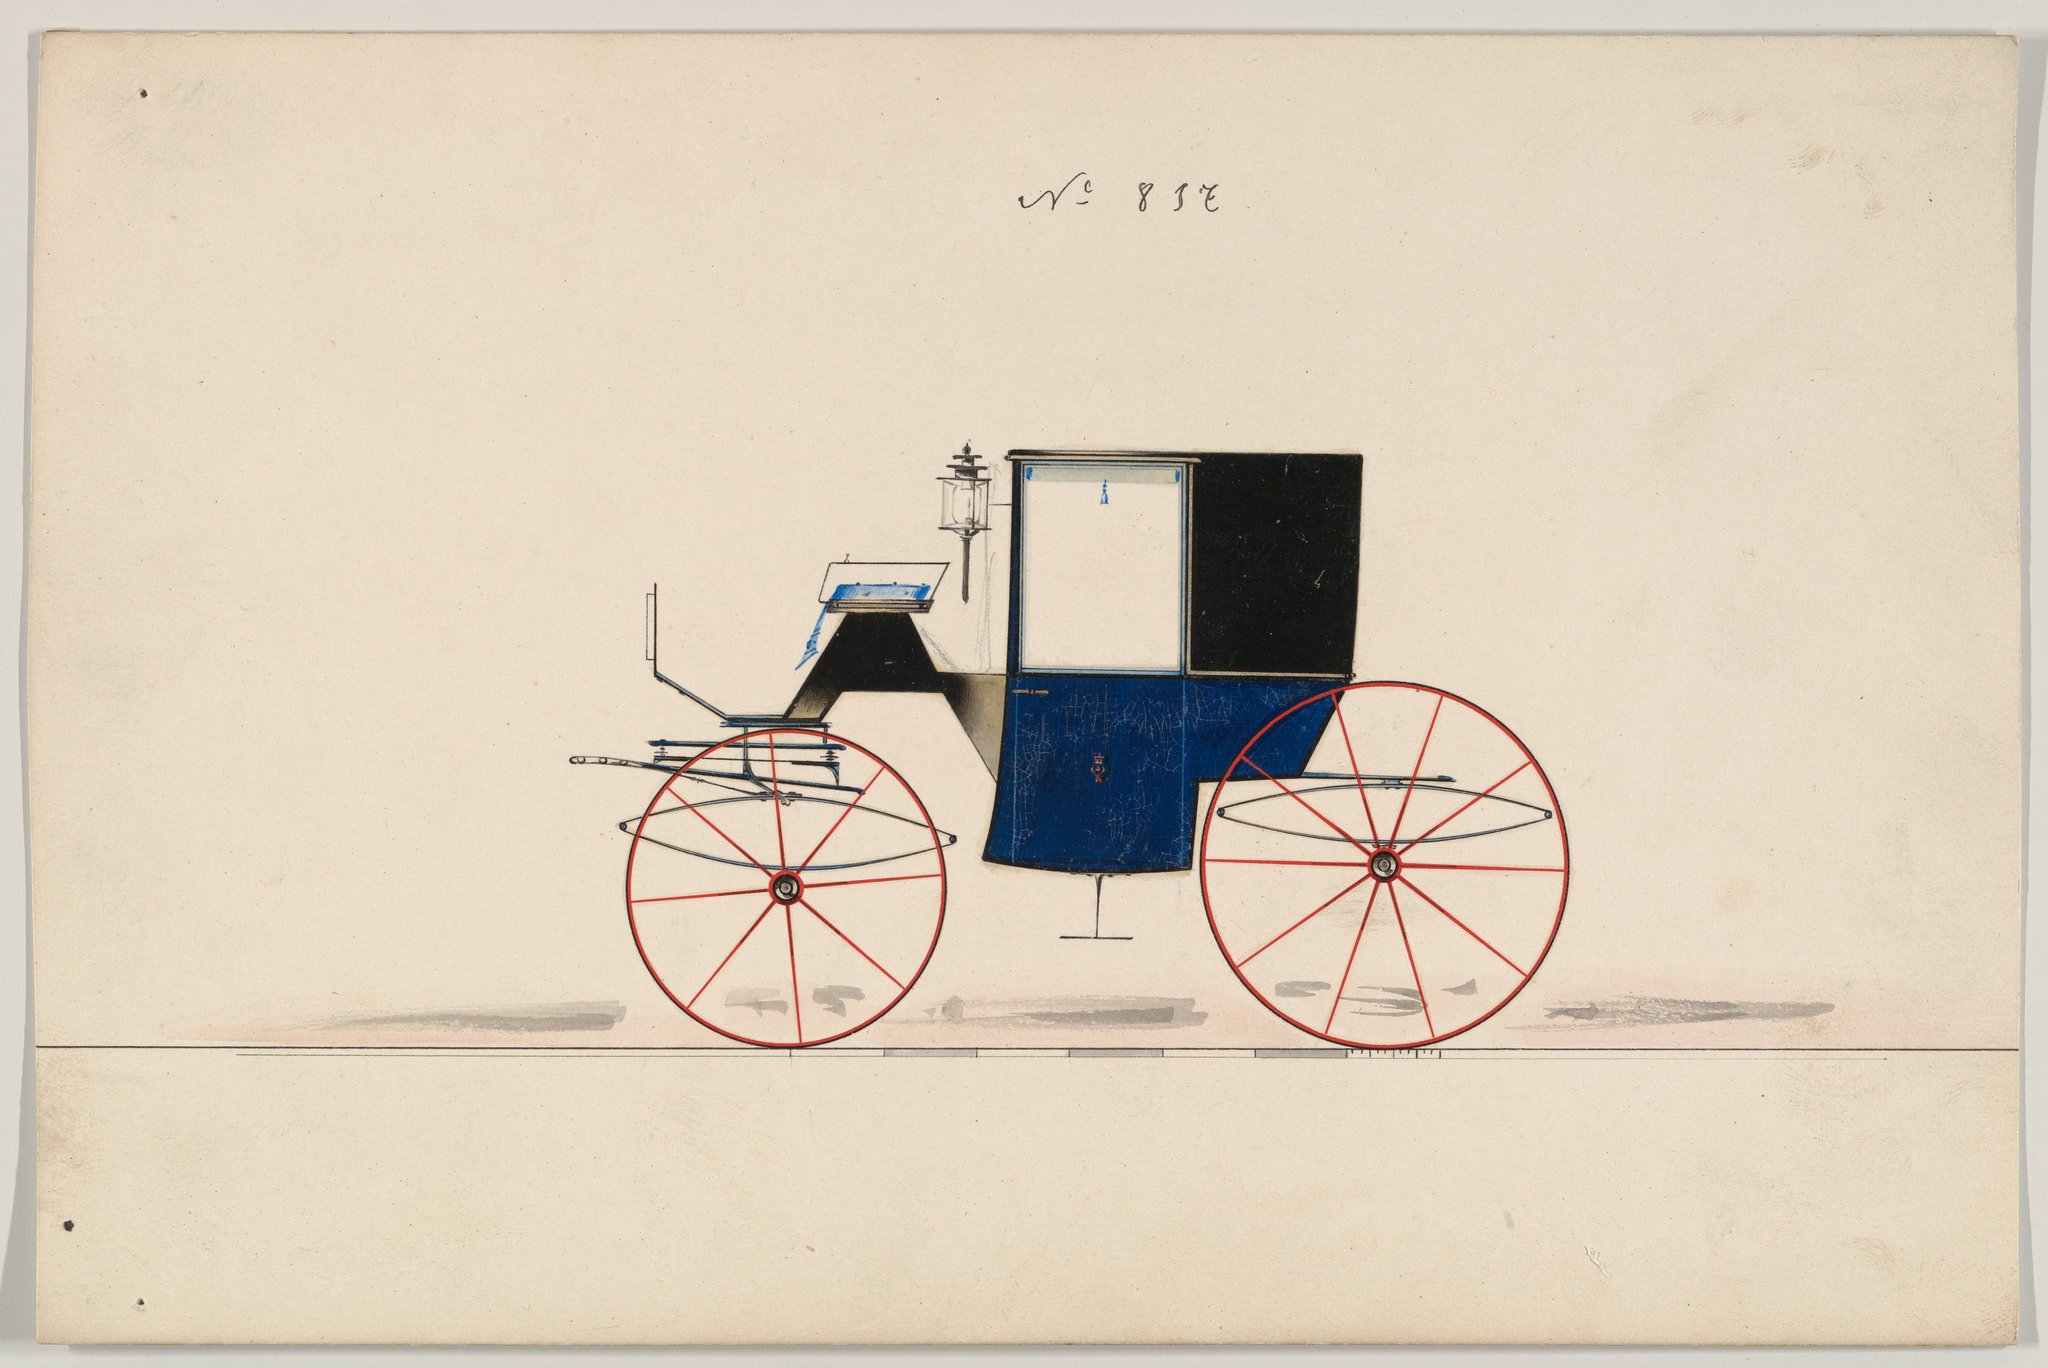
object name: drawing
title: Coupe #817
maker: brewster & co.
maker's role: manufacturer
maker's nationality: american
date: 1865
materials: gouache, graphite, gum arabic, ink, watercolor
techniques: pen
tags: carriages